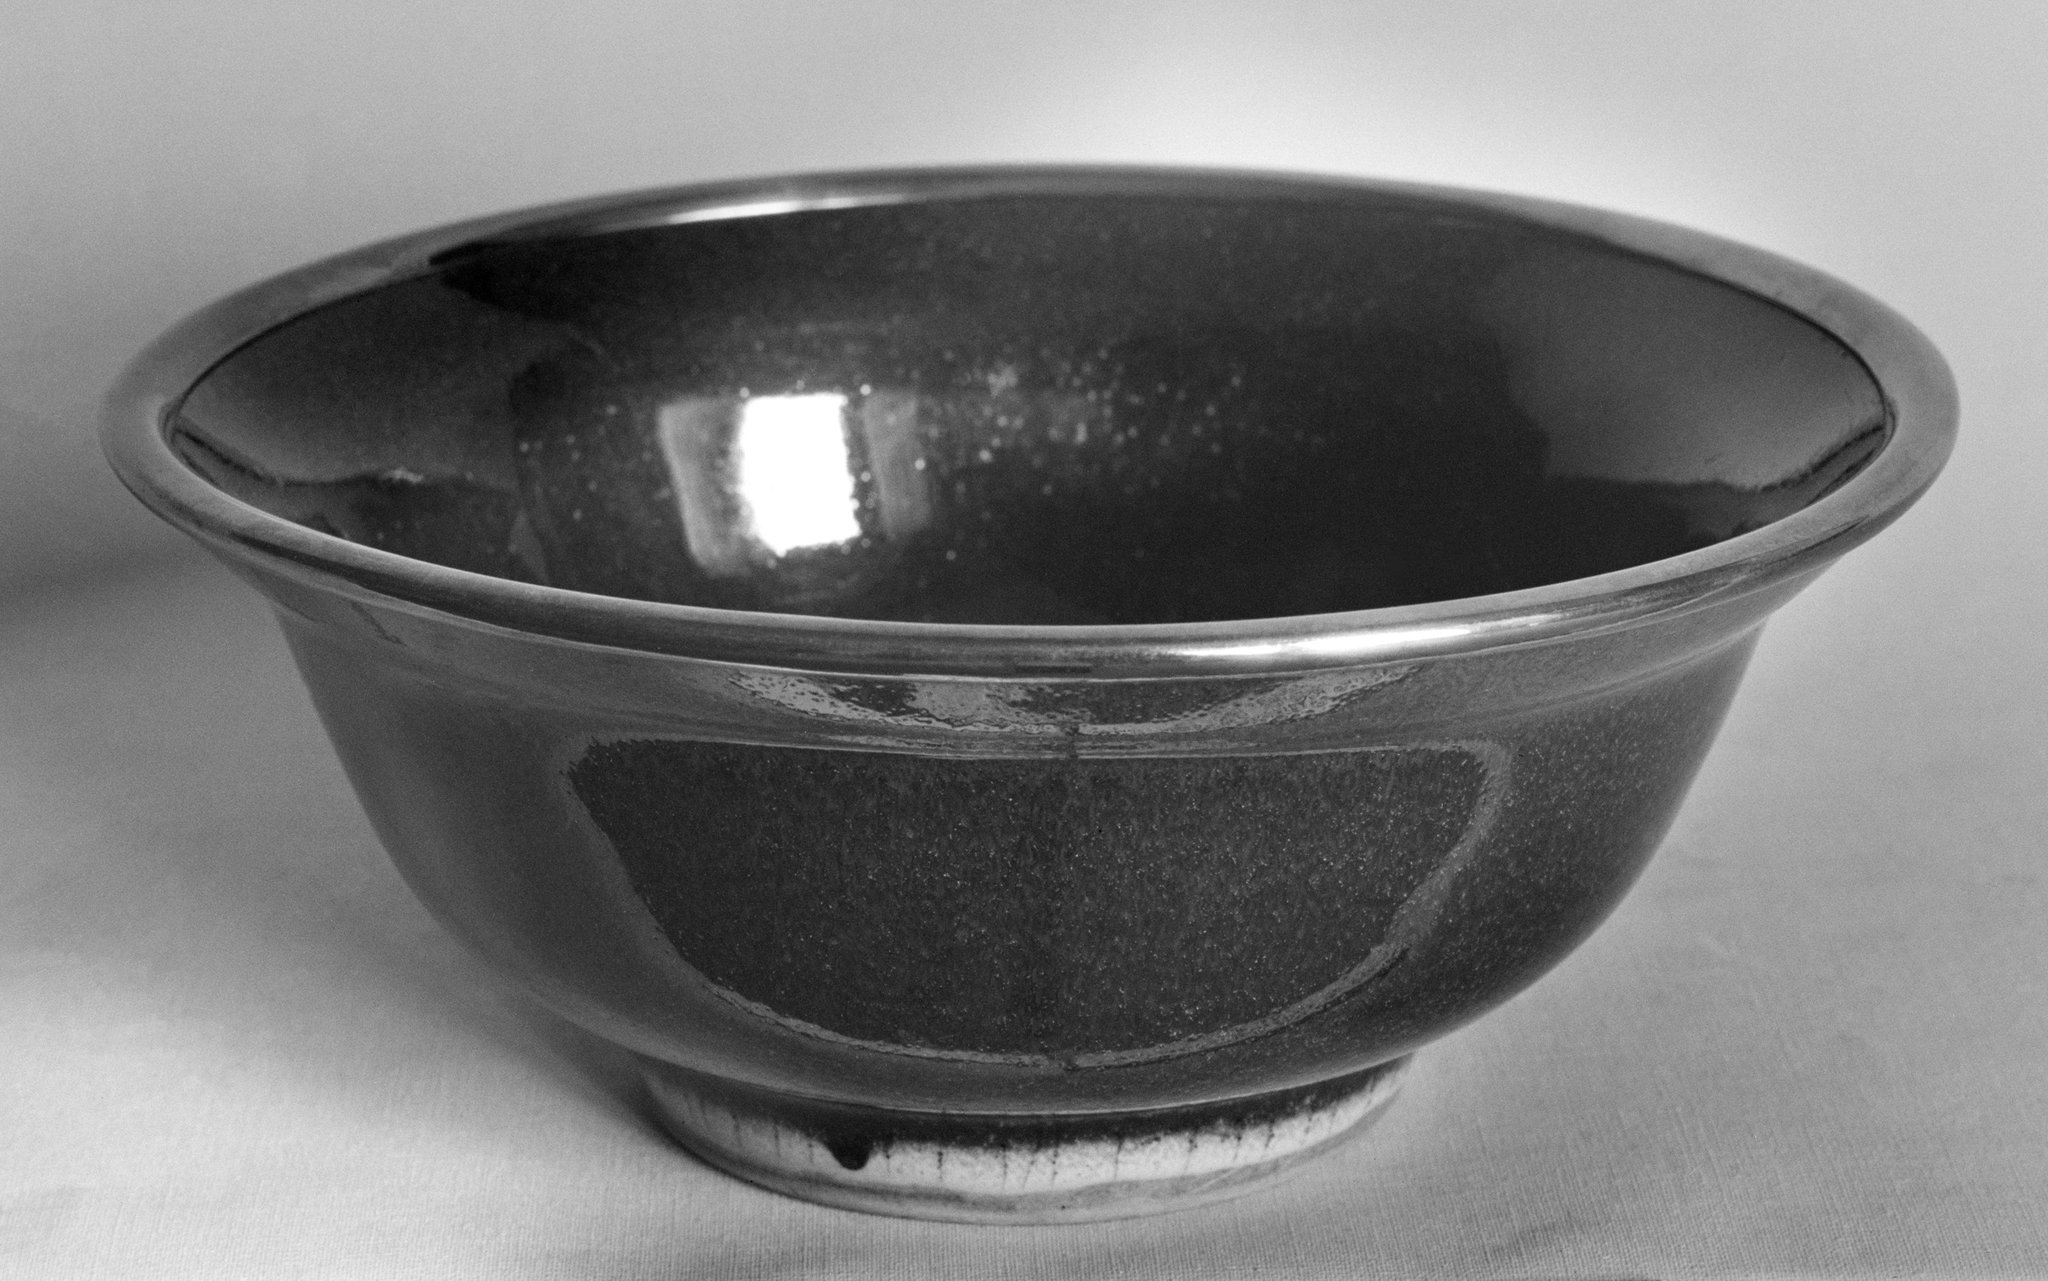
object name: bowl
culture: chinese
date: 1662-1722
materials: glaze, porcelain